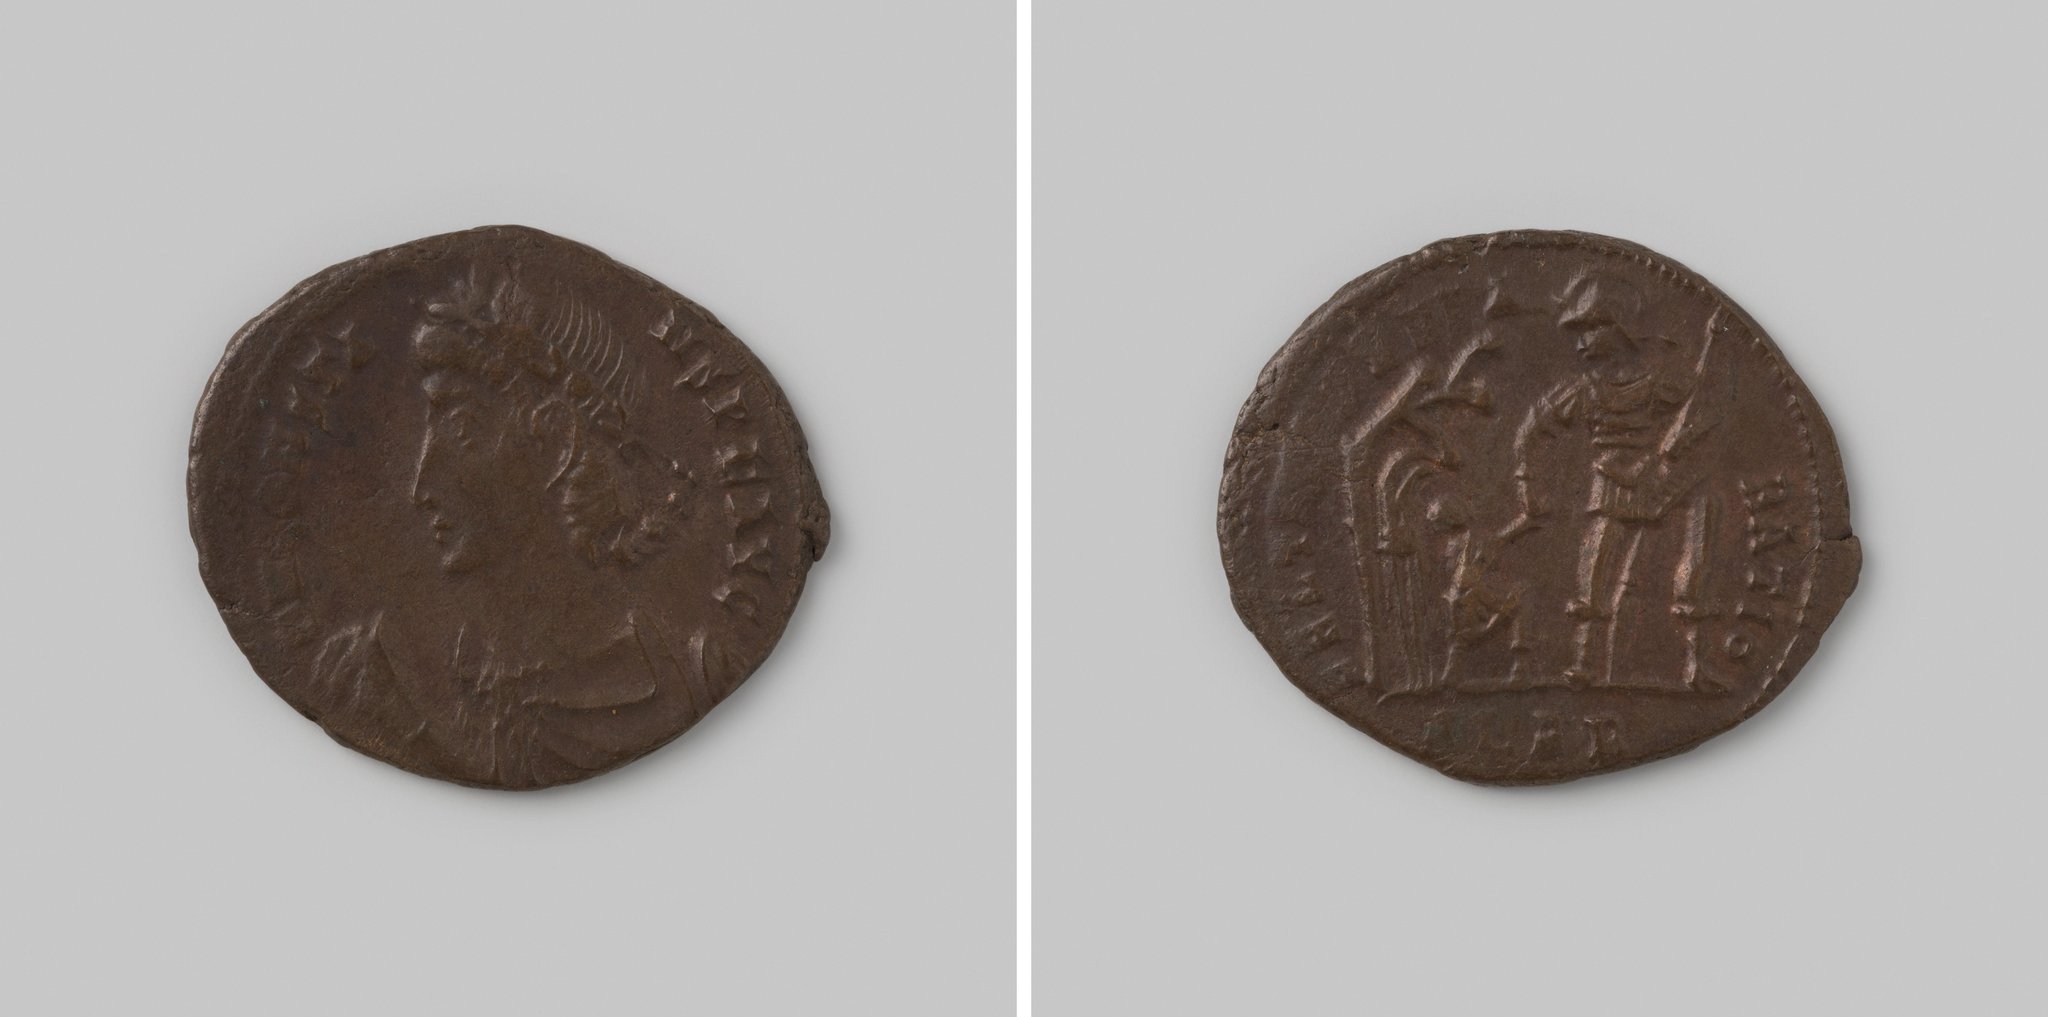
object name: coin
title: (kleine) AE2 uit het Romeinse Keizerrijk van Constans I, 337-350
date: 337-350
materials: bronze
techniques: striking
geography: alexandria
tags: keizer, constans i (keizer van het romeinse rijk)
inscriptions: circumscription: ‘FEL TEMP REPA - RATIO’, inscription: ‘ALEA’, circumscription: ‘D N CONSTA - NS P F AVG’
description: keerzijde: naar rechts lopende soldaat, kind links van hem uit hut onder een boom voerend, speer in linkerhand, in de afsnede de letters ALEF